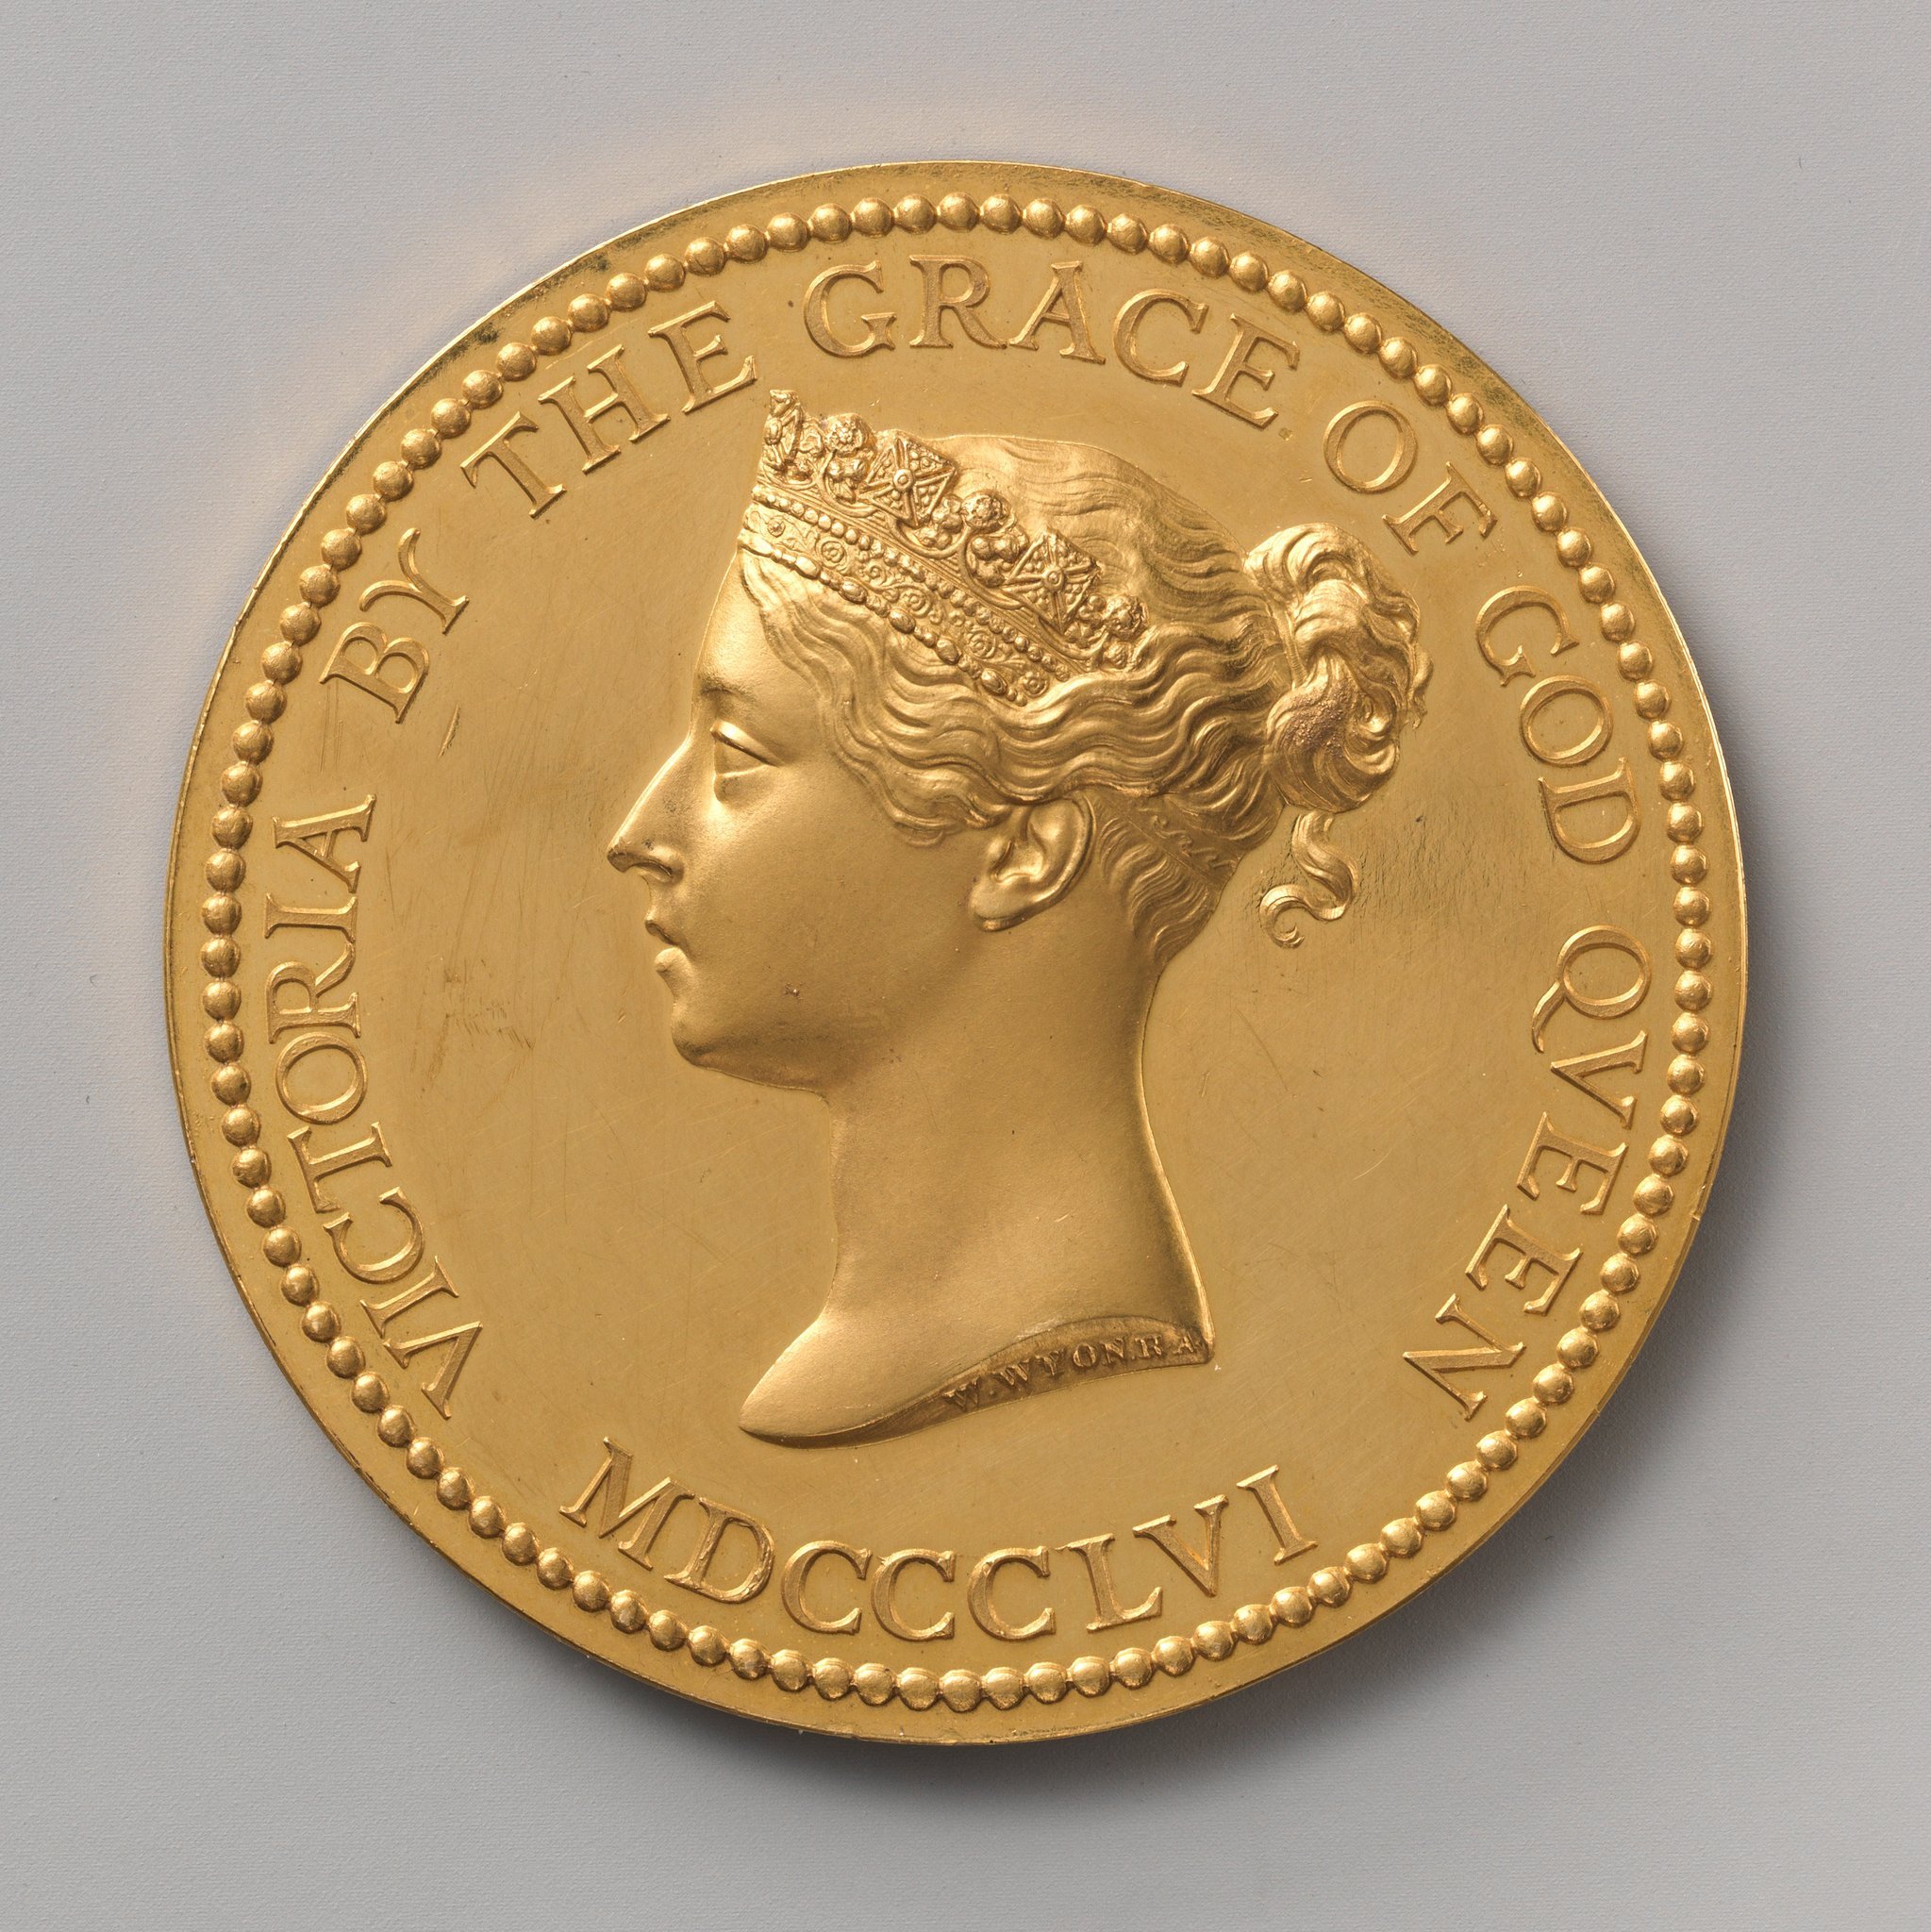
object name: medal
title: For Success in Art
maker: william wyon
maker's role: artist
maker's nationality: british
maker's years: 1795-1851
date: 1856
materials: gold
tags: profiles,women